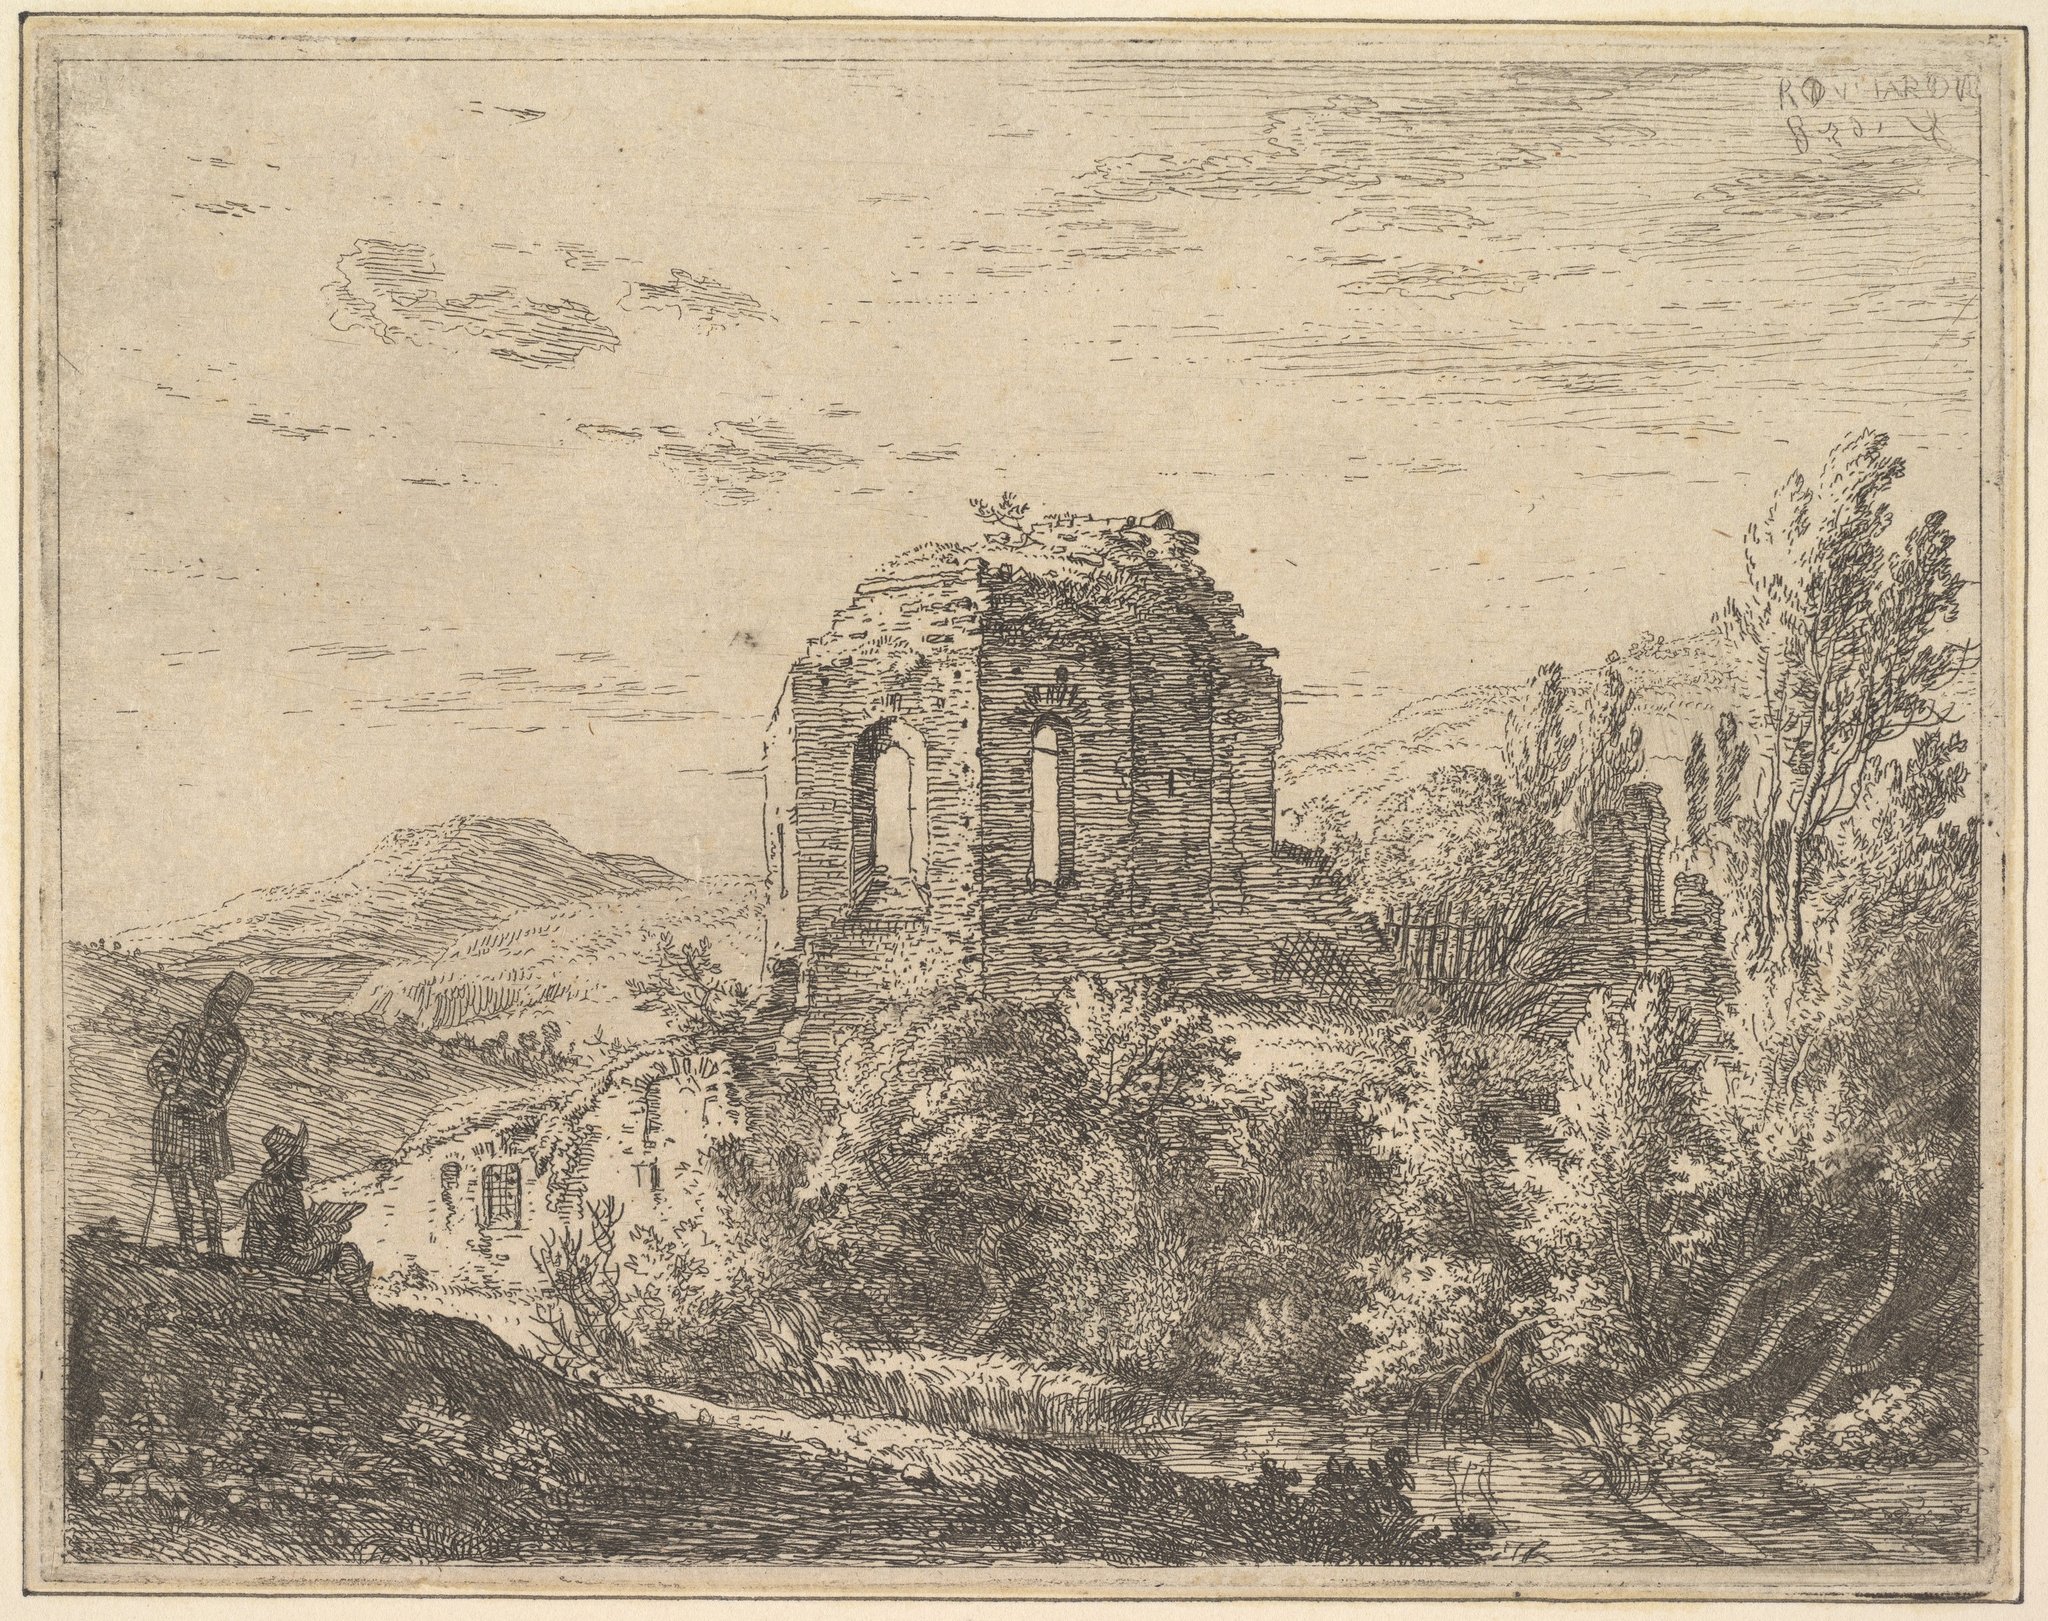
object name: print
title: View of ruins showing the corner of a building with two arched windows, in a landscape with a stream in the foreground, from a series of four plates showing ruins of a single building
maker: karel dujardin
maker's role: artist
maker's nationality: dutch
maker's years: 1622-1678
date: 1658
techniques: etching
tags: ruins,landscapes